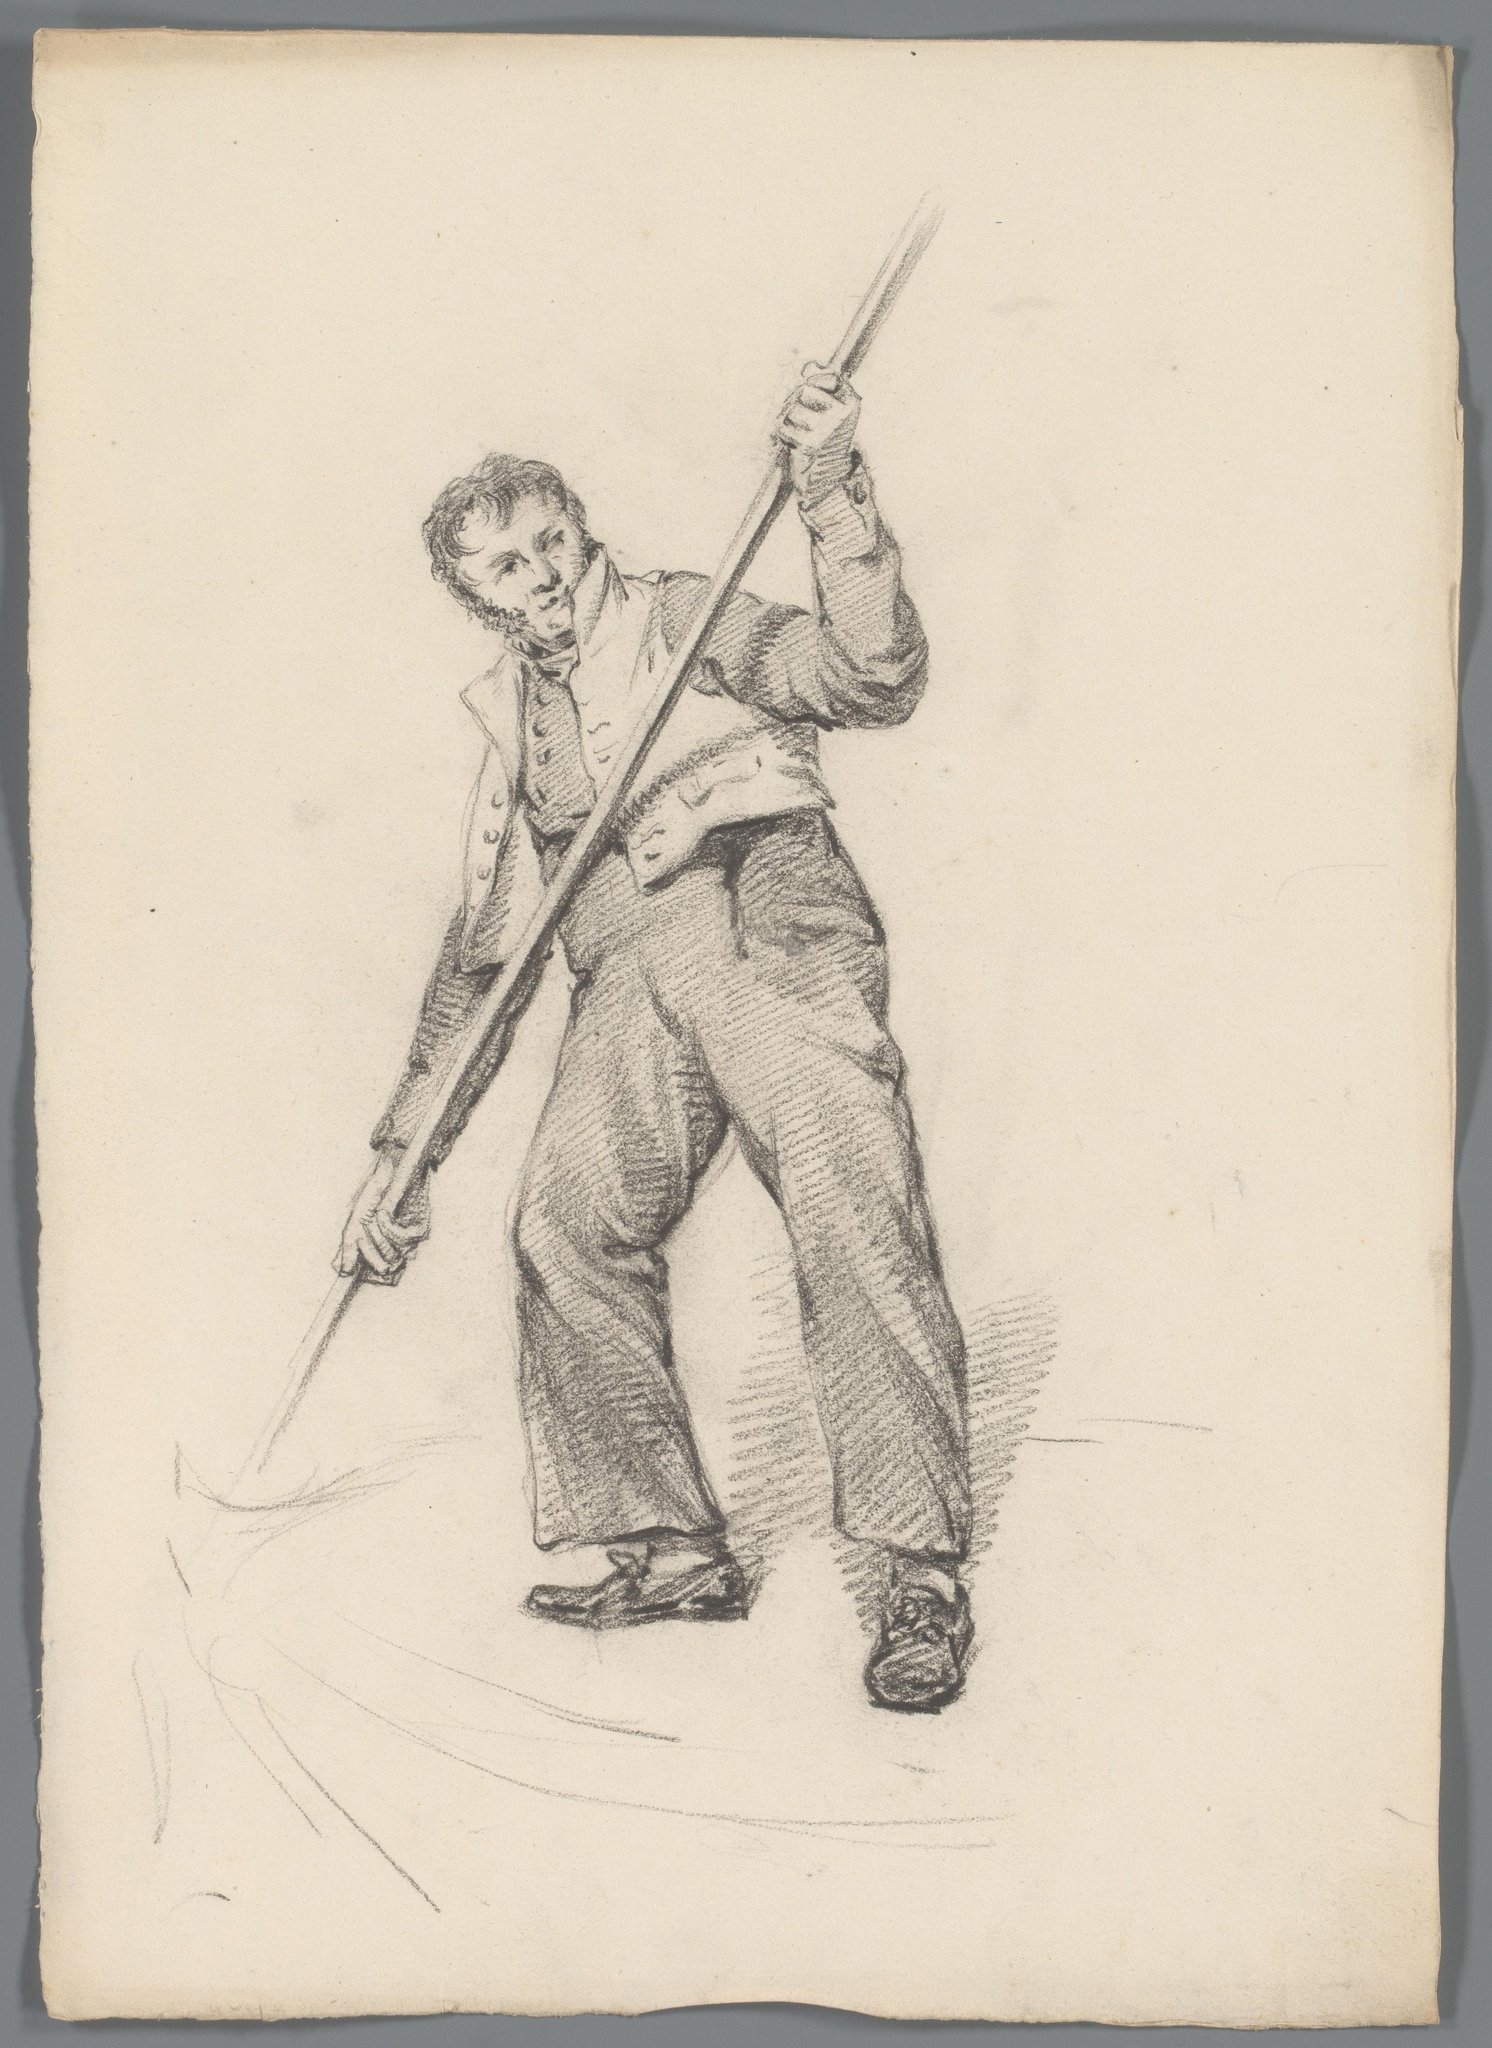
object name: drawing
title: Man met een stok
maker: Anonymous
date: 1820-1830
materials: chalk, paper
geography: the hague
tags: adult man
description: Tekeningen waarschijnlijk ontstaan bij het Haagse kunstgenootschap ‘Tot Nut der Tekenkunst’, waar twee keer per week tekenavonden werden georganiseerd met geklede modellen.